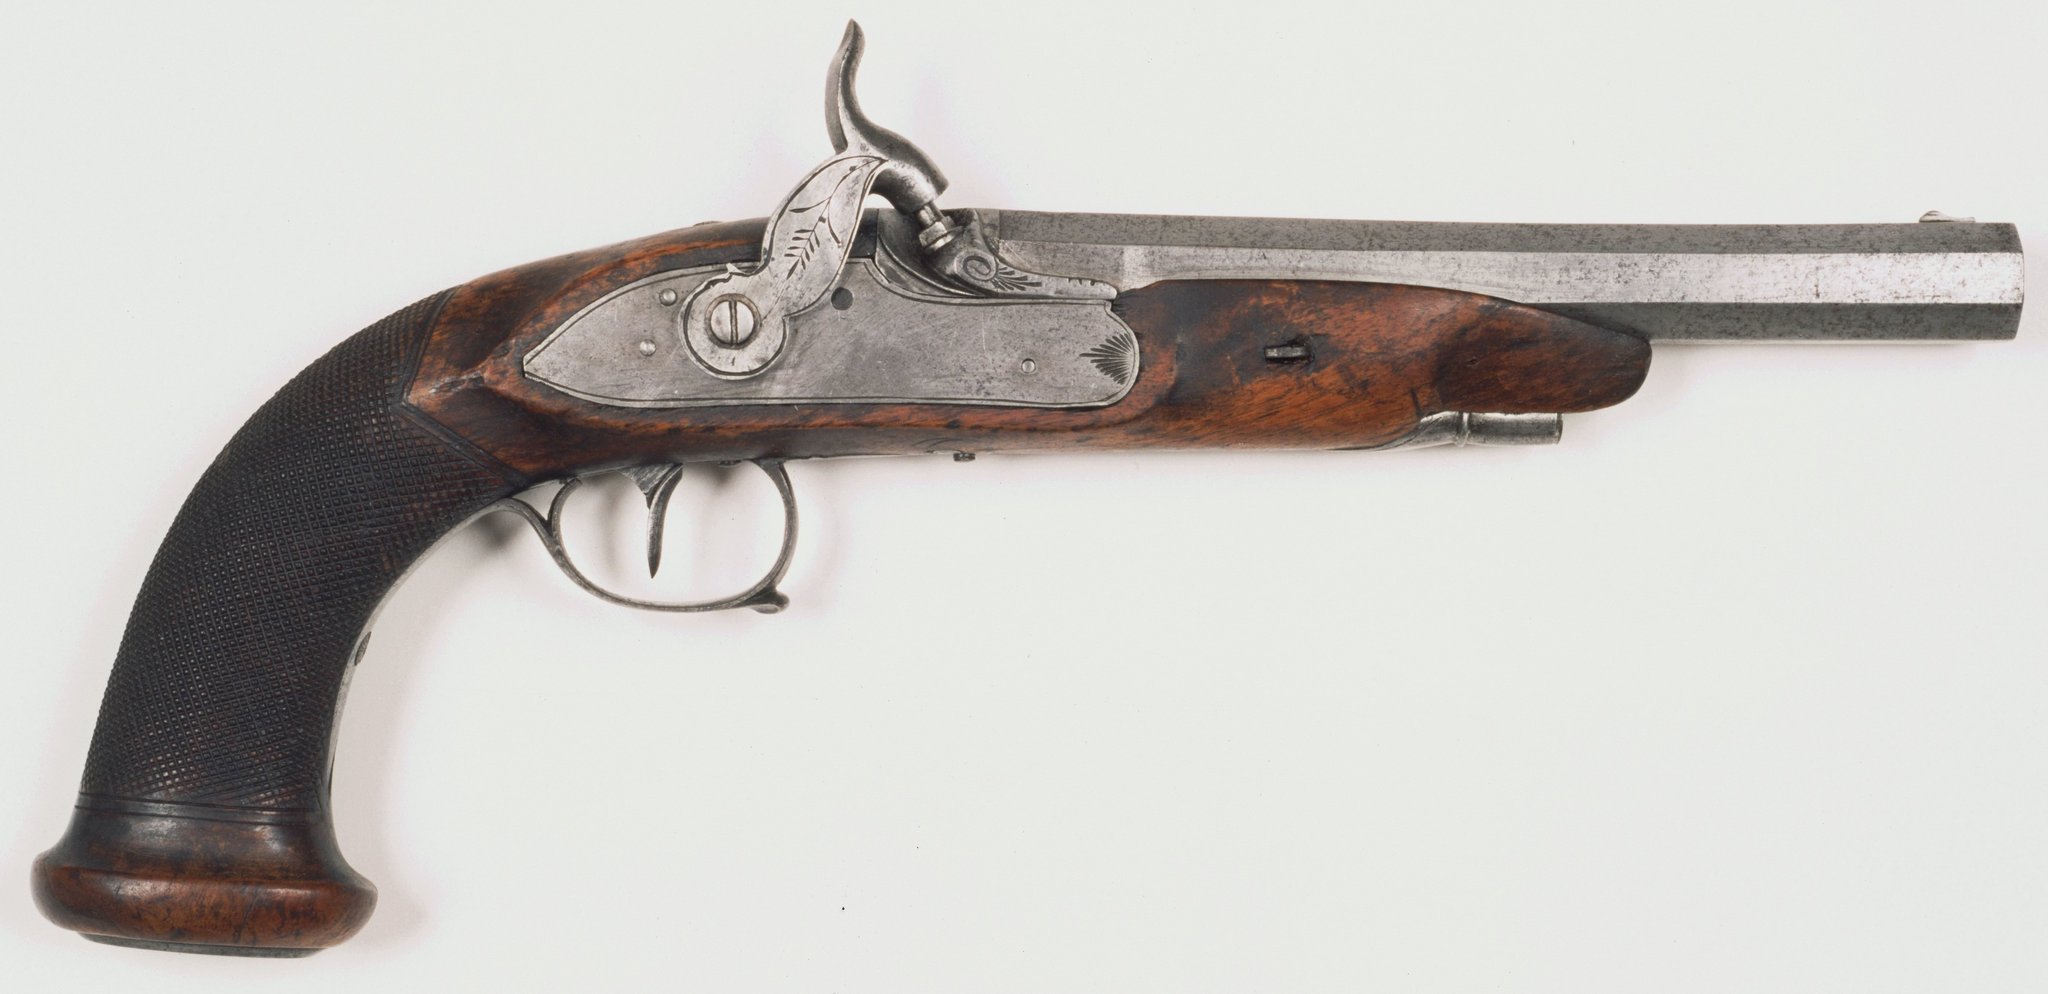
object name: percussion pistol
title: Percussiepistool met achtkantige gebruineerde gladde loop met houten laadstok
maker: Anonymous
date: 1831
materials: iron, wood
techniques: burnishing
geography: western europe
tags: belgium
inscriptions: mark: ‘E LG’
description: Percussiepistool met achthoekige gladde ijzeren loop met aan het uiteinde een ijzeren vizierkorrel. IJzeren platte slotkast met gegraveerde versieringen, op de haan een ingekerfde bladmotief. Houten lade die overgaat in een geribbelde kolf, op de kolfkop een ijzeren gegraveerde plaat met een ingekerfde ster. Linkerzijde van de lade ijzeren beslag met plantmotieven. Onder de lade een laadstokkoker met ijzeren buitenkant, de laadstok ontbreekt.